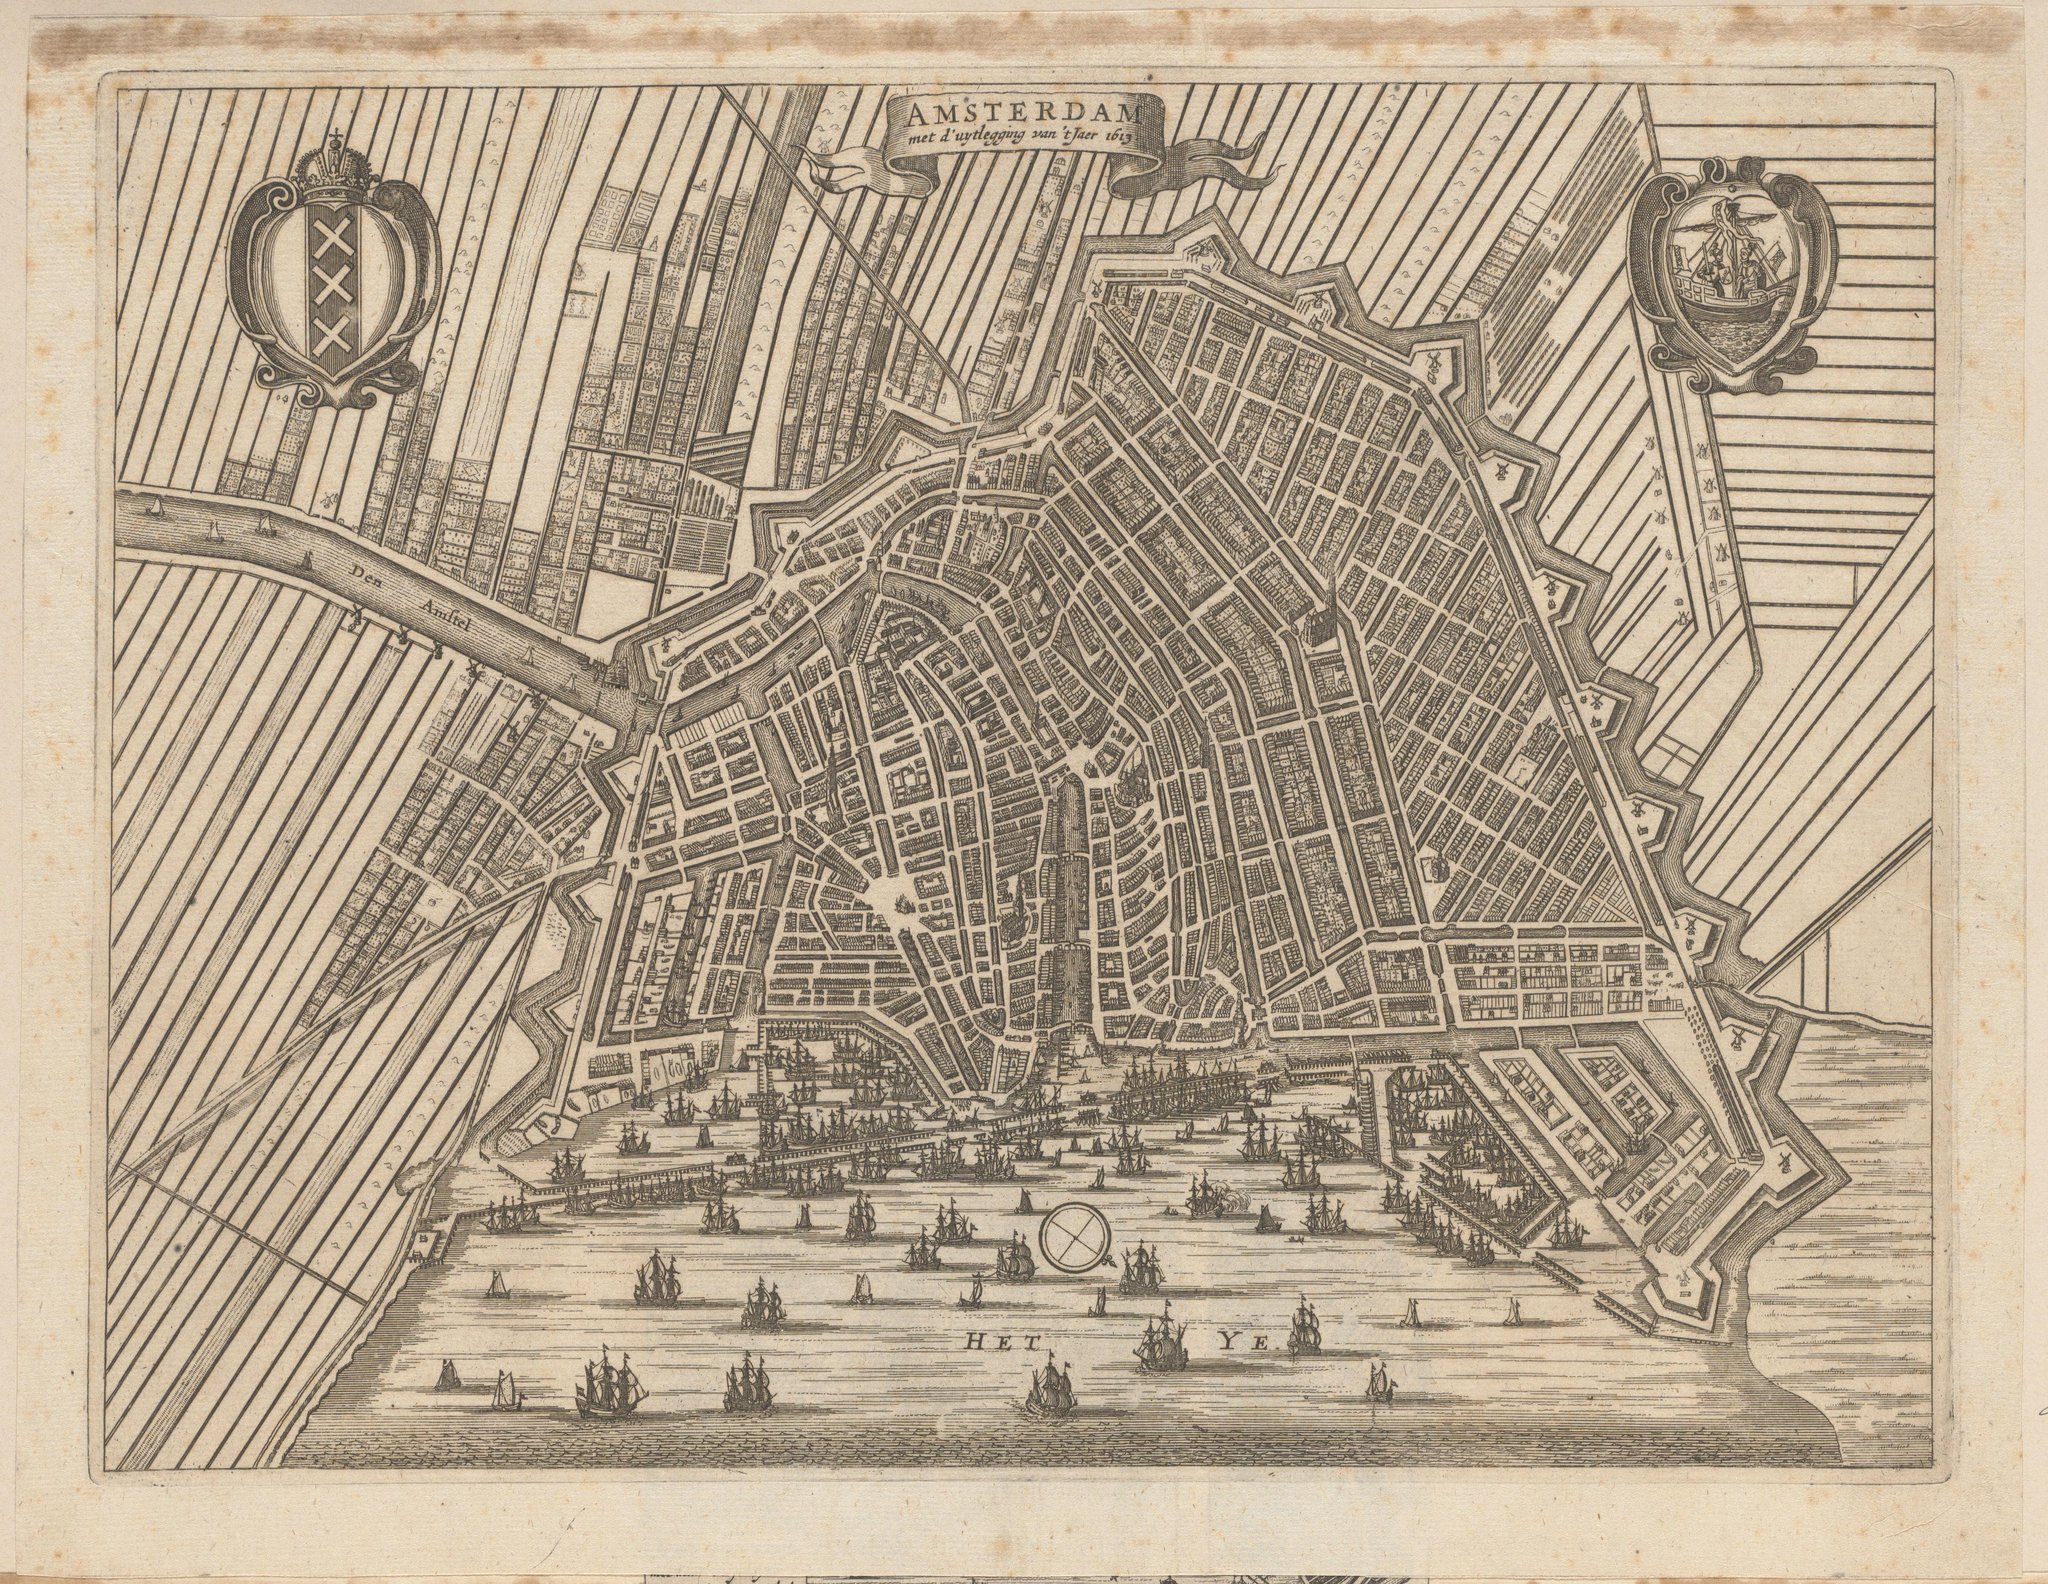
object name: print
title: Plattegrond van Amsterdam, 1613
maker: jacob van meurs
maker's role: draughtsman, print maker, publisher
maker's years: 1619-1680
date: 1663-1694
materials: paper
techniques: engraving, etching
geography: northern netherlands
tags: coat of arms (as symbol of the state, etc.) (+ city; municipal), seal (as symbol of the state, etc.) (+ city; municipal), maps of cities, amsterdam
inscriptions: collector's mark: Lugt 1641b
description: Prent mogelijk uit: Dapper, Olfert. Historische beschryving der stadt Amsterdam (…). Amsterdam: Jacob van Meurs, 1663. Of uit: Zesen, Philipp von. Beschreibung der Stadt Amsterdam (…). Amsterdam: Joachim Nosche, 1664. Of uit: Commelin, Casparus. Beschryvinge van Amsterdam (…). Amsterdam: Abraham Wolfgang, Gillis Janssonius van Waesberge of Johannes Janssonius van Waesberge, Hendrick Boom of weduwe Dirk Boom, Abraham van Sanderen en Rembertus Goethals, 1693. Of uit: Commelin, Casparus. Beschryvinge van Amsterdam (…). Amsterdam: weduwe Aart Dircksz. Oossaan, 1694.